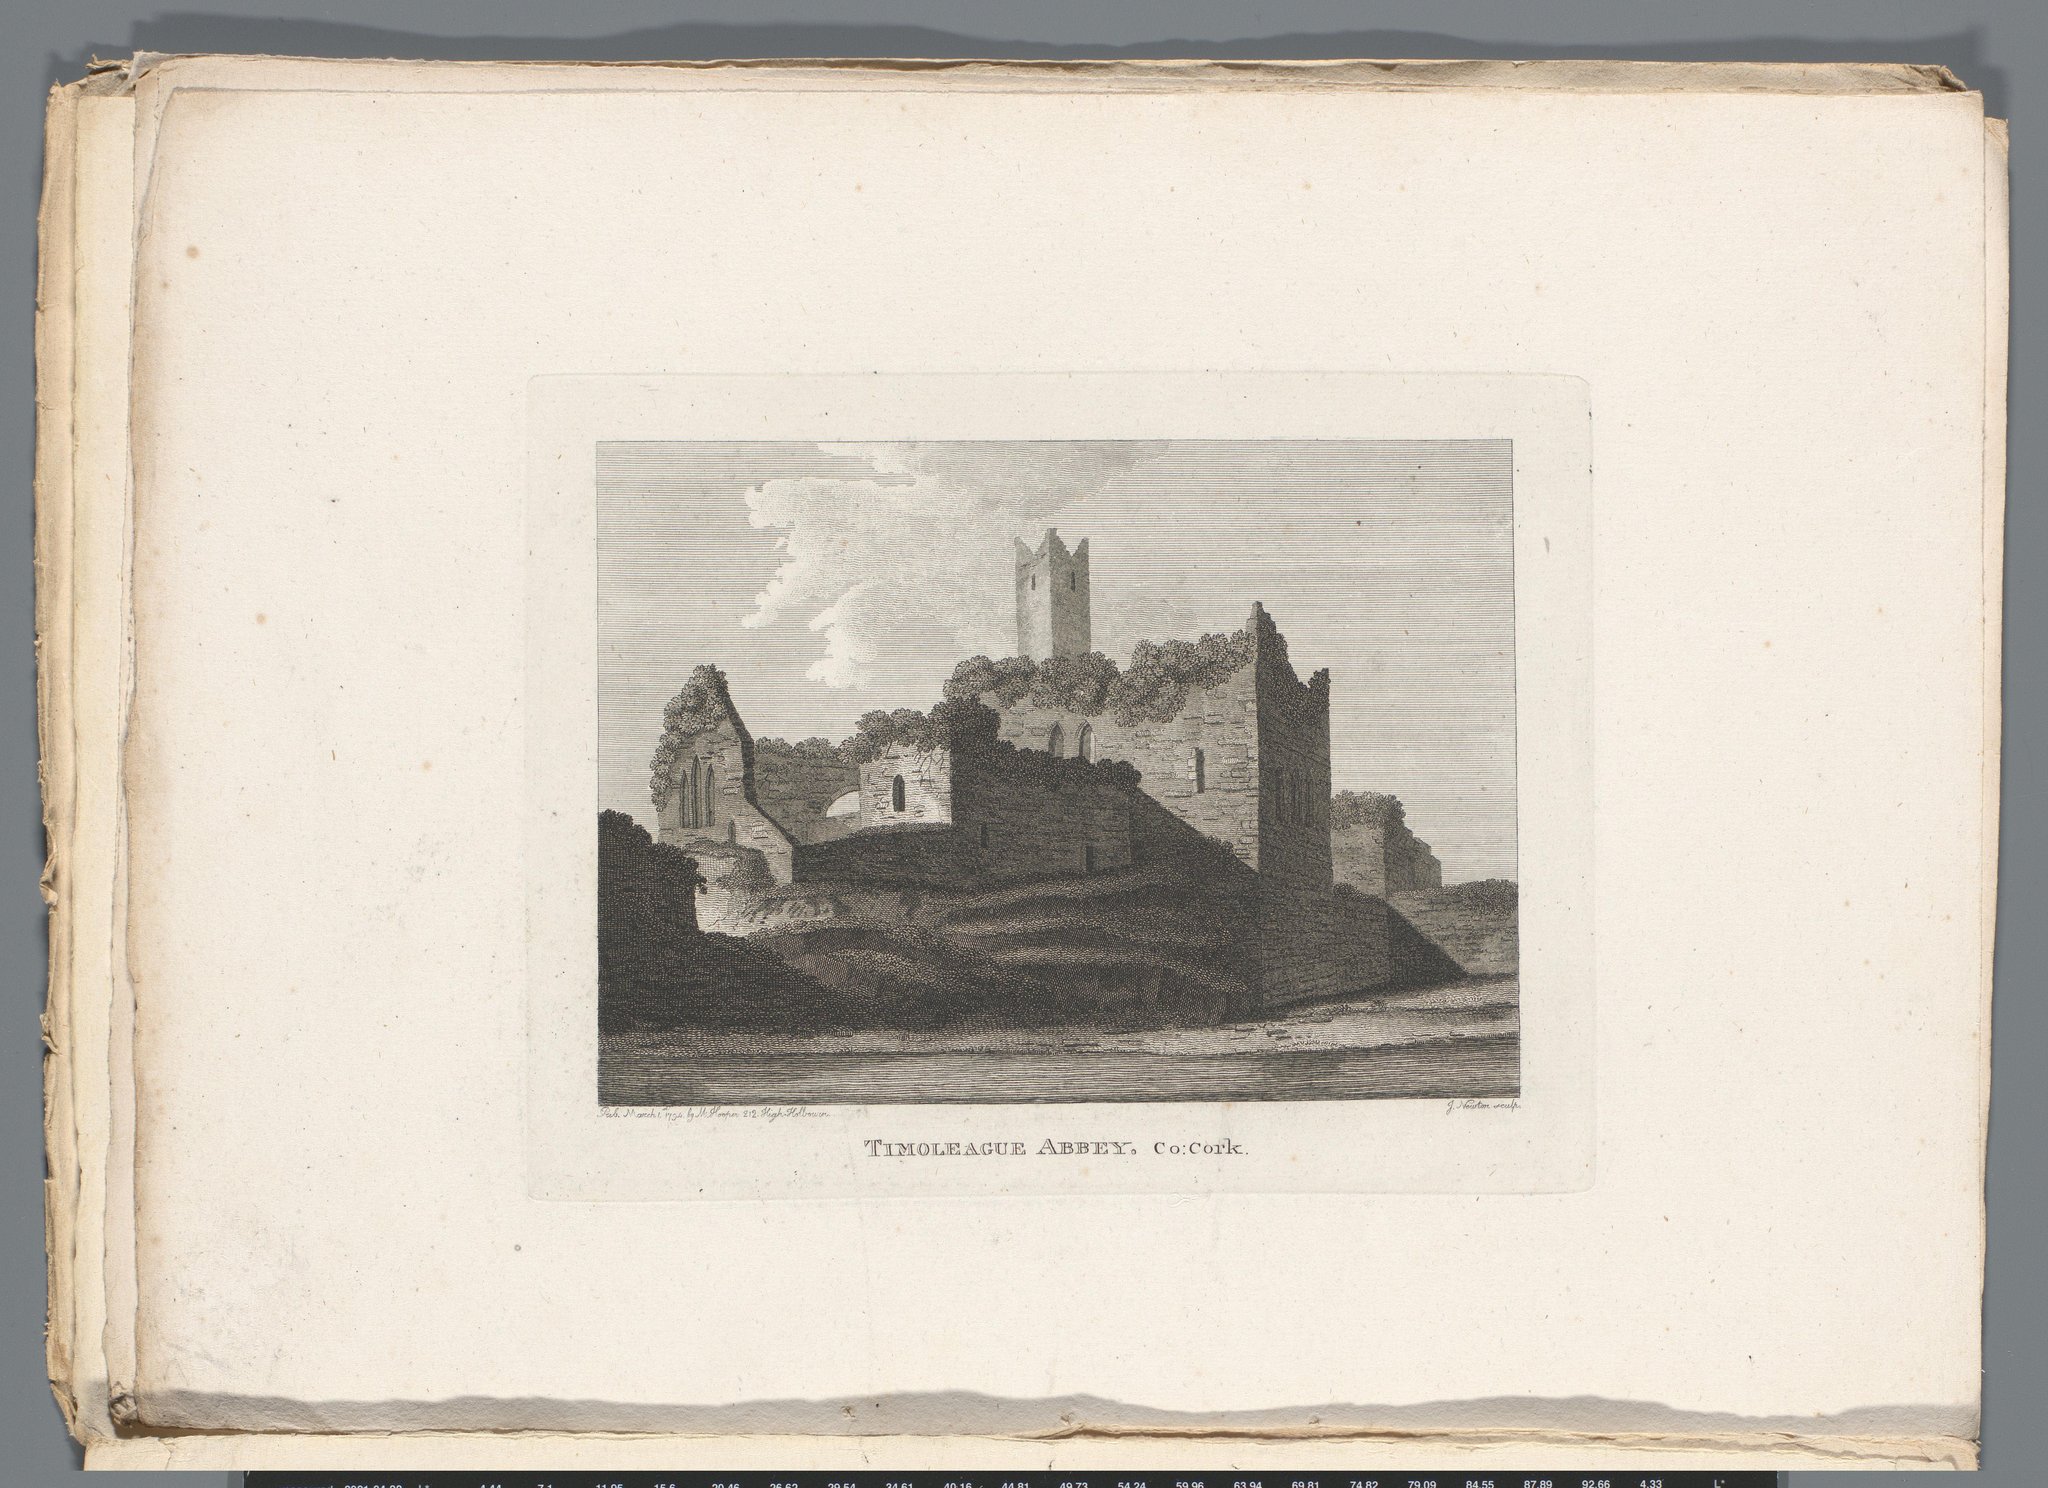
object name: book illustration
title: Gezicht op de ruïnes van de abdij van Timoleague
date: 1794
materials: paper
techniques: etching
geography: london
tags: city-view, and landscape with man-made constructions, abbey, monastery, convent ~ roman catholic church, landscape with ruins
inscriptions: date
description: Prent verschenen in: Grose, Francis. The antiquities of Ireland. Londen: S. Hooper, 1795, dl. 2.